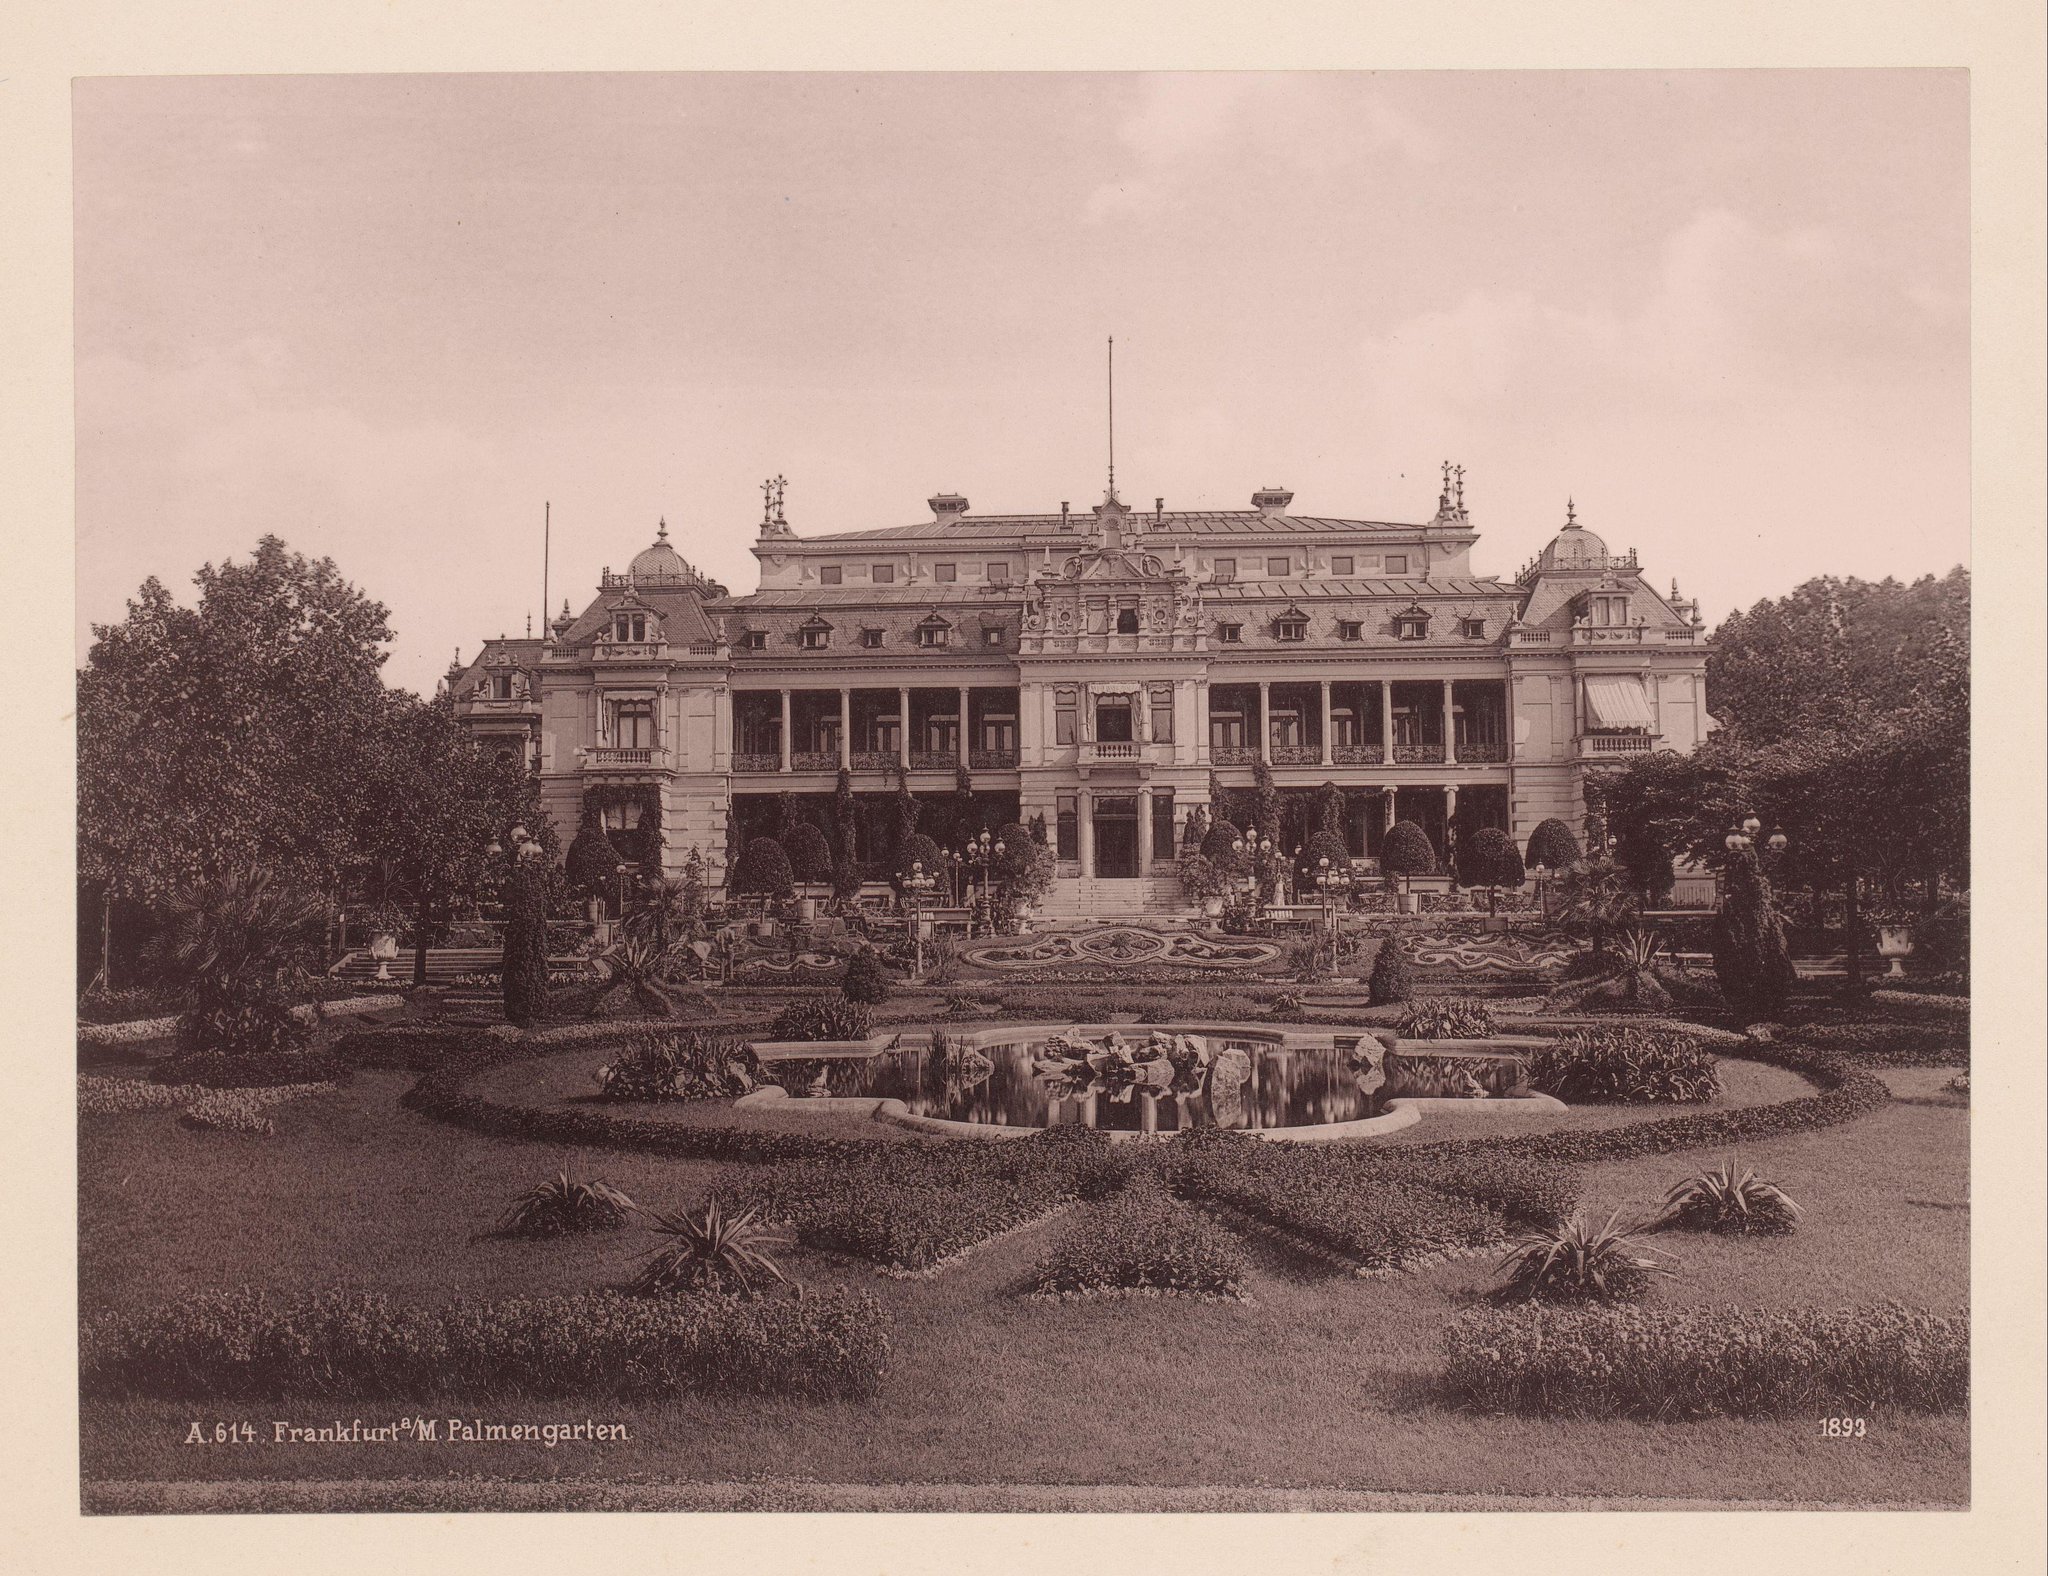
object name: photograph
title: Het "Gesellschaftshaus" in de "Palmengarten", Frankfurt am Main, Duitsland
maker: Anonymous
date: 1893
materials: cardboard, paper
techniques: albumen print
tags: frankfurt am main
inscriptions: date: ‘1893’, inscription: ‘A. 614. Frankfurt a/M. Palmengarten.’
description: Het "Gesellschaftshaus"in de "Palmengarten" - deze botanische tuin werd in 1868 opgericht, en op 16 maart 1871 geopend.